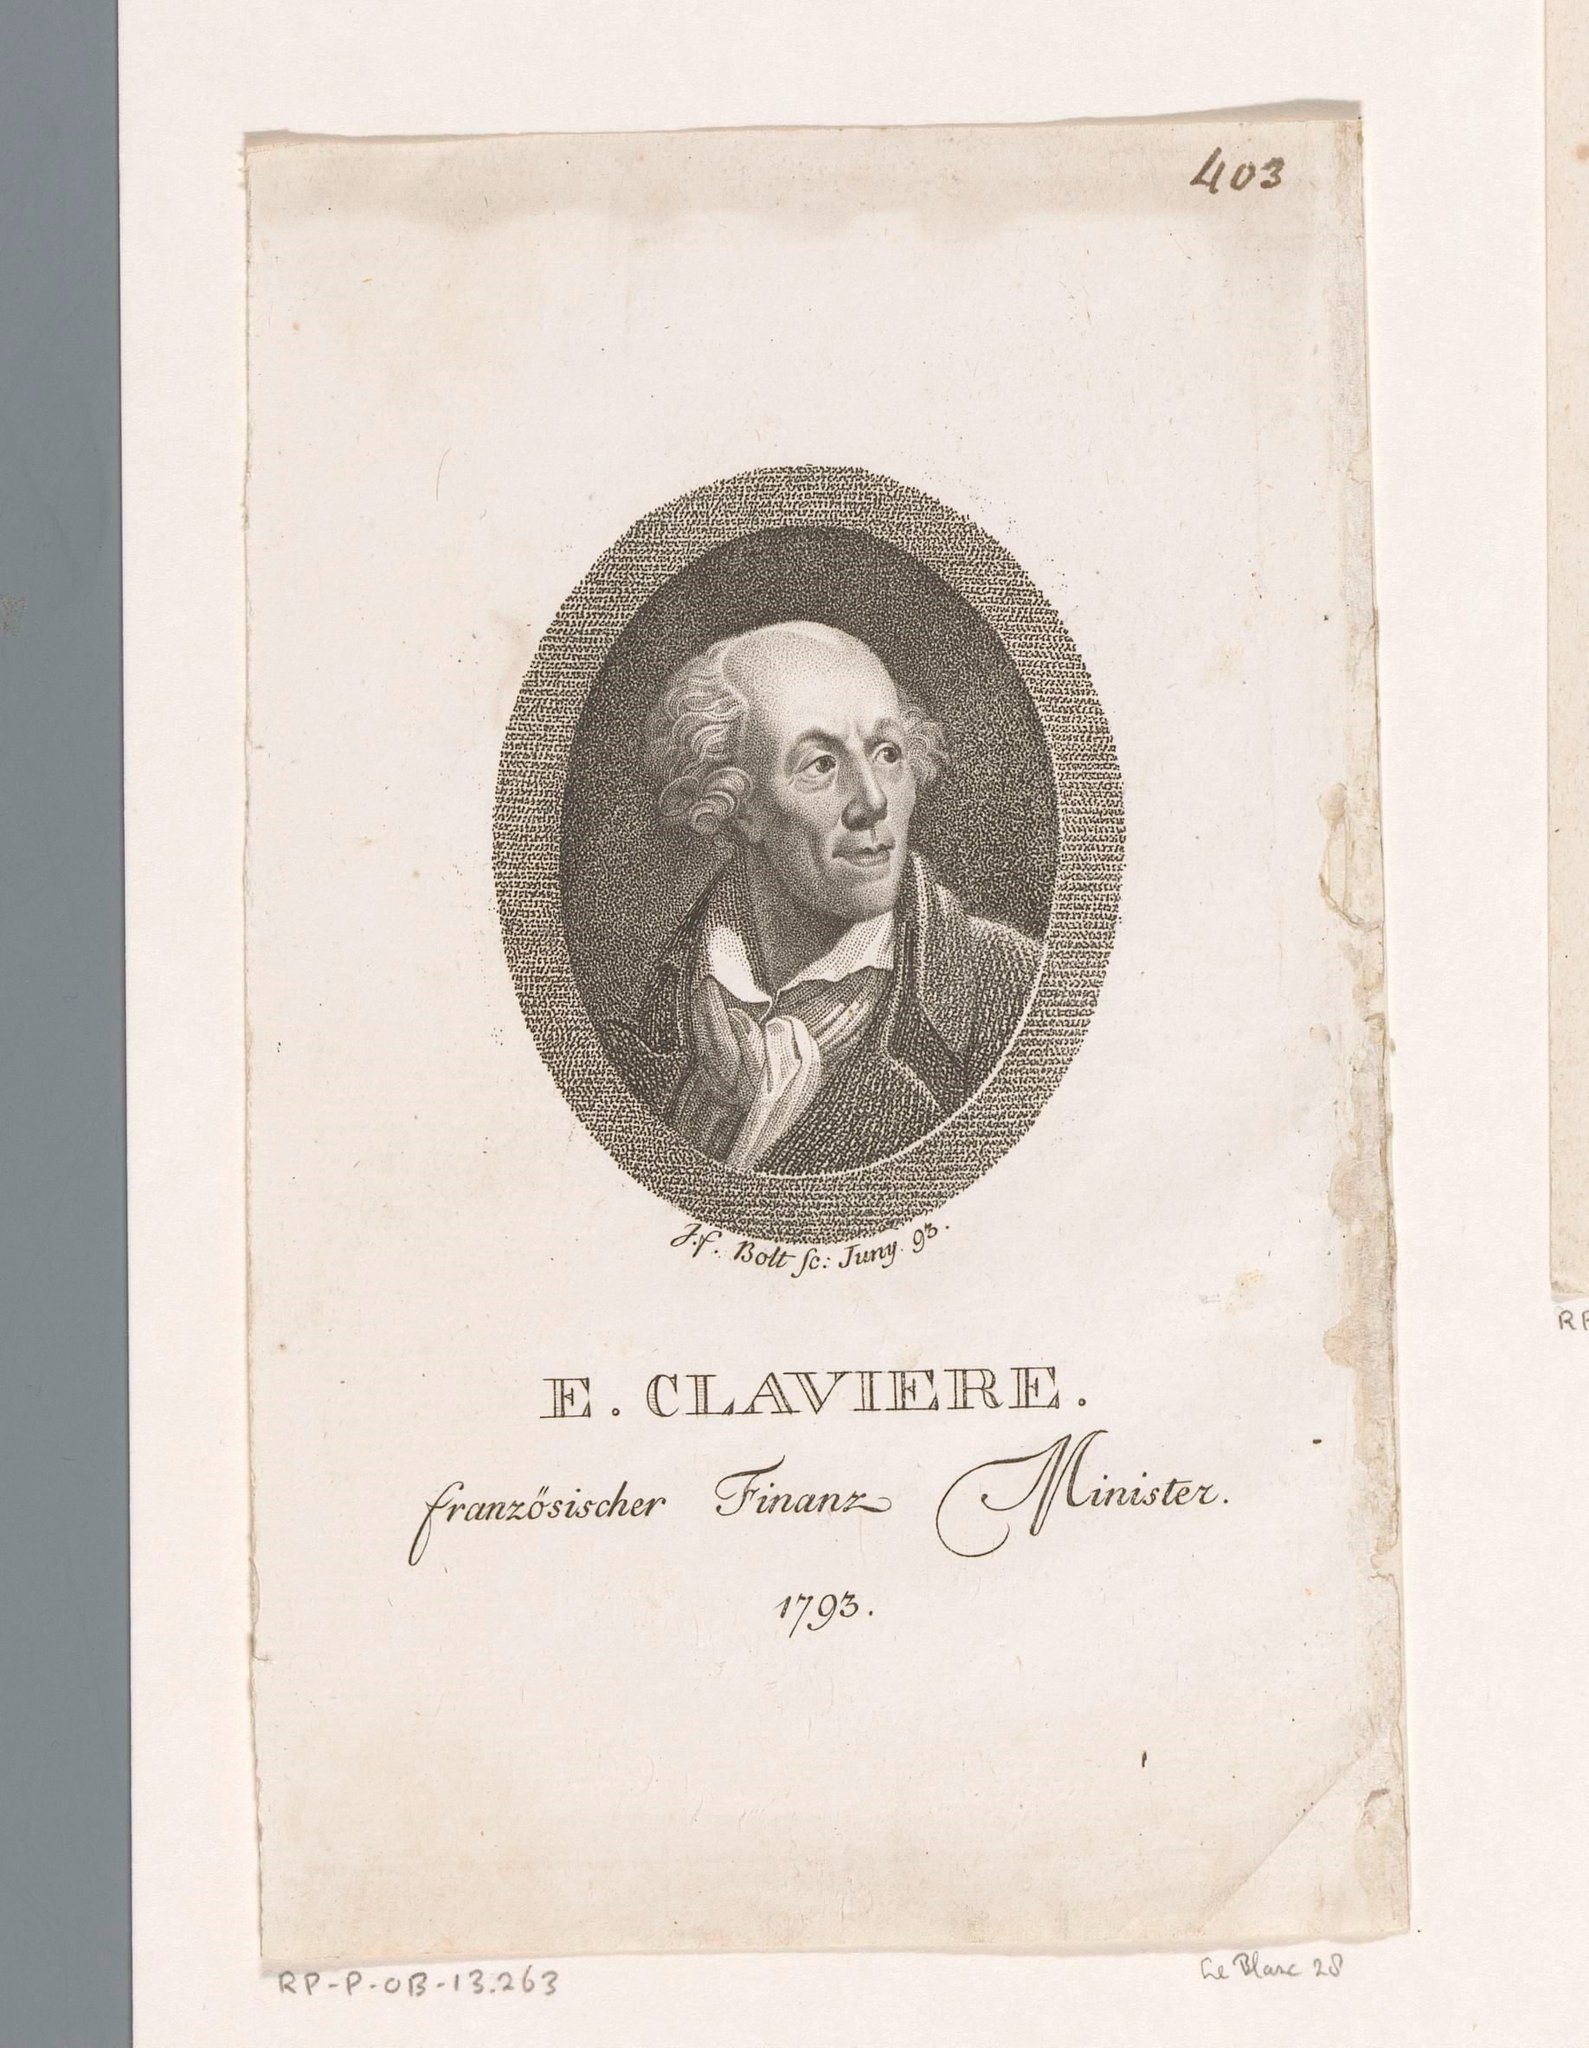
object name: book illustration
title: Portret van Étienne Clavière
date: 1706-1793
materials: paper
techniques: stippling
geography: hamburg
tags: historical persons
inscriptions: date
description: Prent afkomstig uit: Minerva. Ein Journal historischen und politischen Inhalt [uitgegeven door:] Johann Wilhelm Archenholz. Erster Band. April, May, Juny 1793. Hamburg: Johann Wilhelm Archenholz en Benjamin Gottlob Hoffmann, [1793].